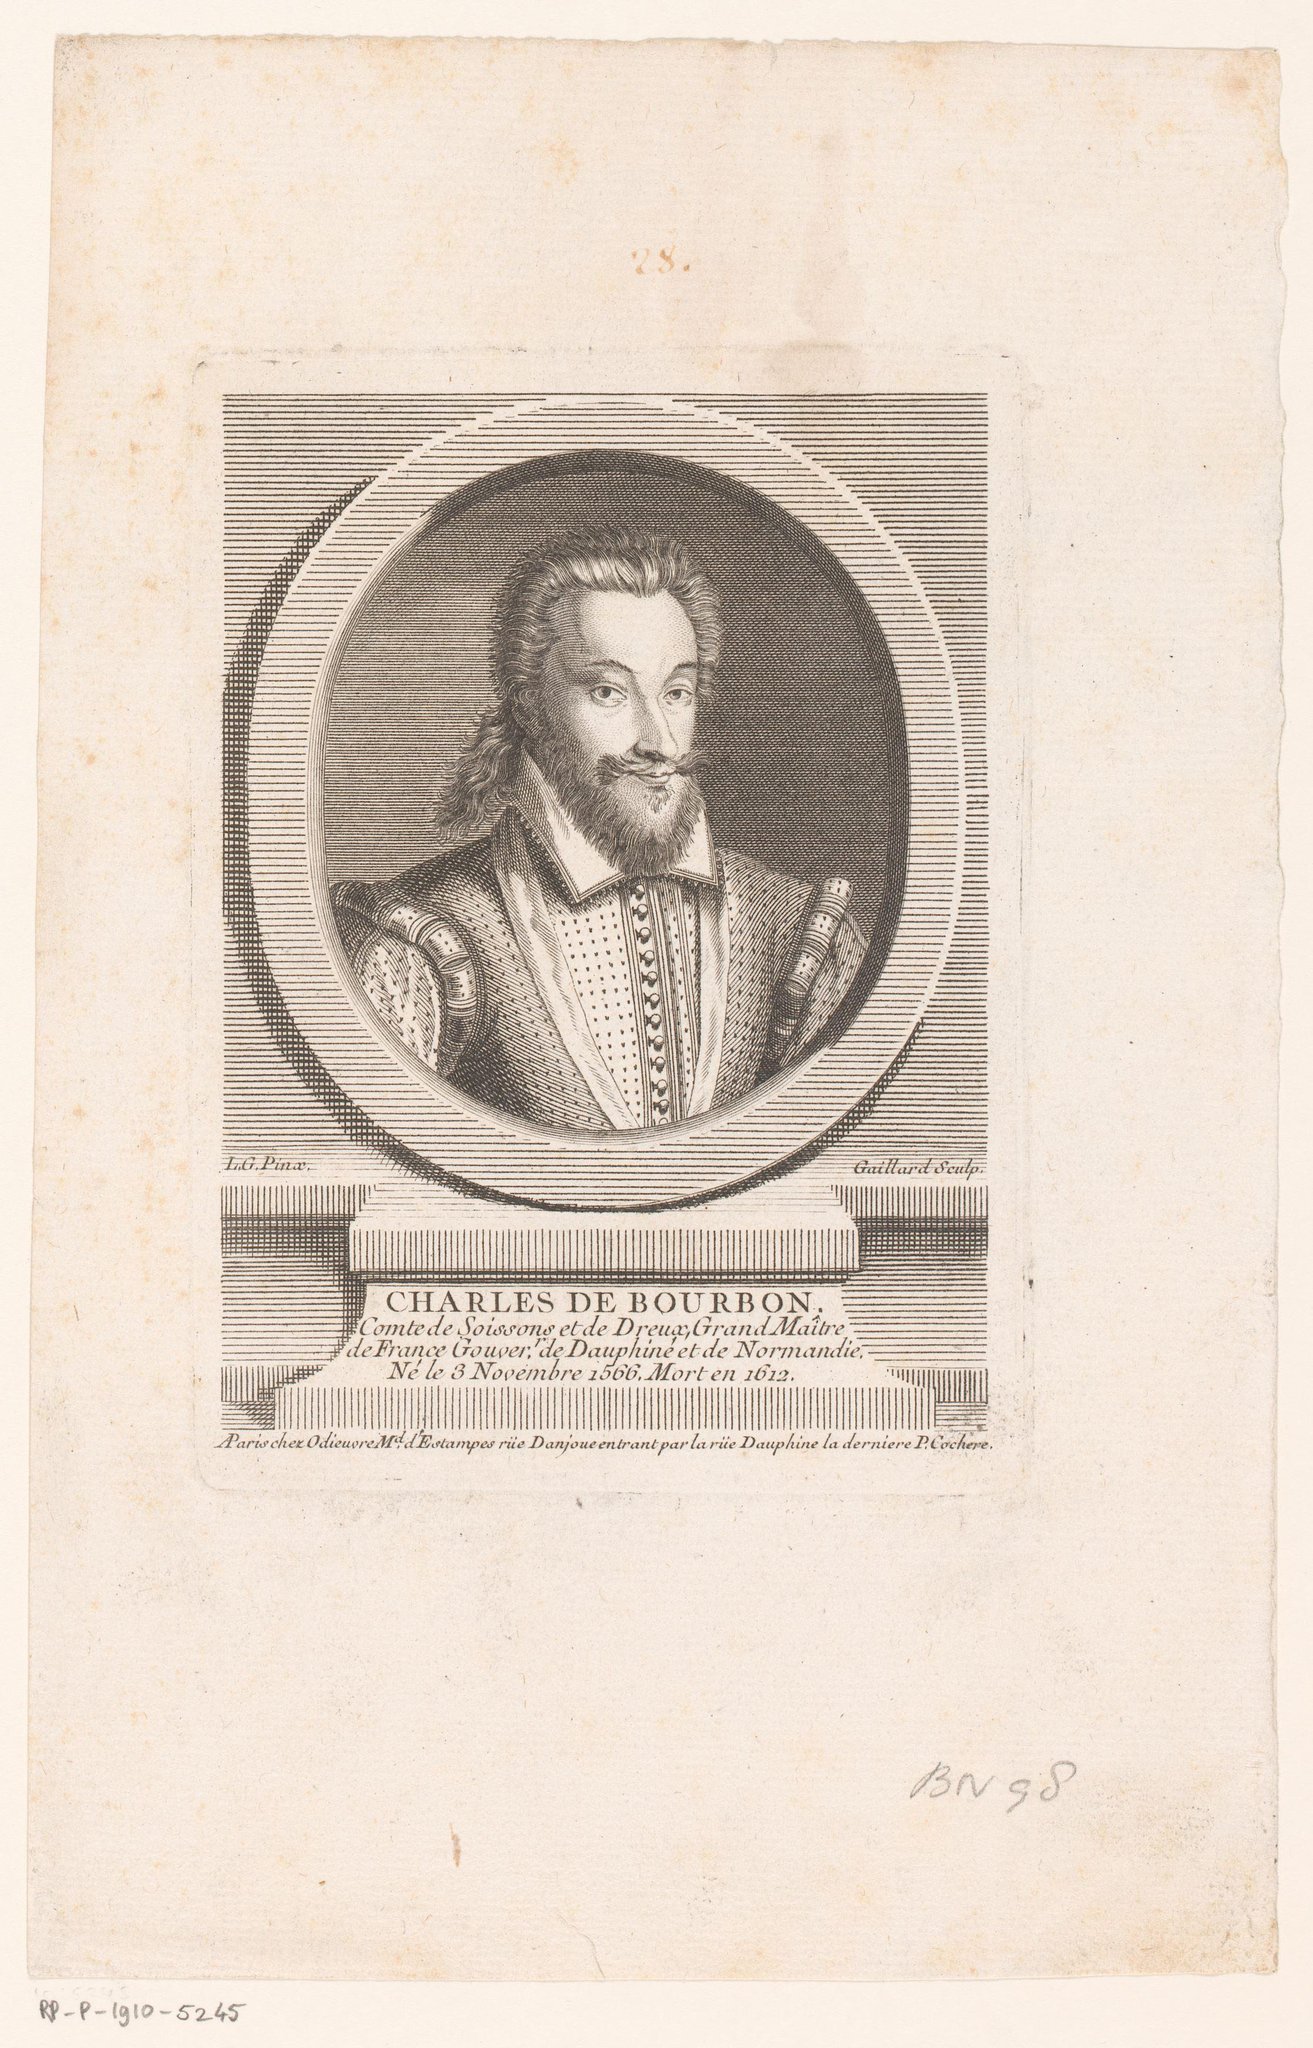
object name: book illustration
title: Portret van Charles de Bourbon, graaf van Soisson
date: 1755-1765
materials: paper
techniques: engraving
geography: paris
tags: earl, historical persons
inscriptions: collector's mark: Lugt 2228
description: Mogelijk prent uit: Dreux du Radier, Jean-François. L'Europe illustré, contenant l'histoire abregée des souverains, des princes, des prélats, des ministres, (...) en Europe: dans le XVe. siècle compris, jusqu'à présent. Parijs: Michel Odieuvre en André-François Le Breton, 1755-1765, dl. 3.